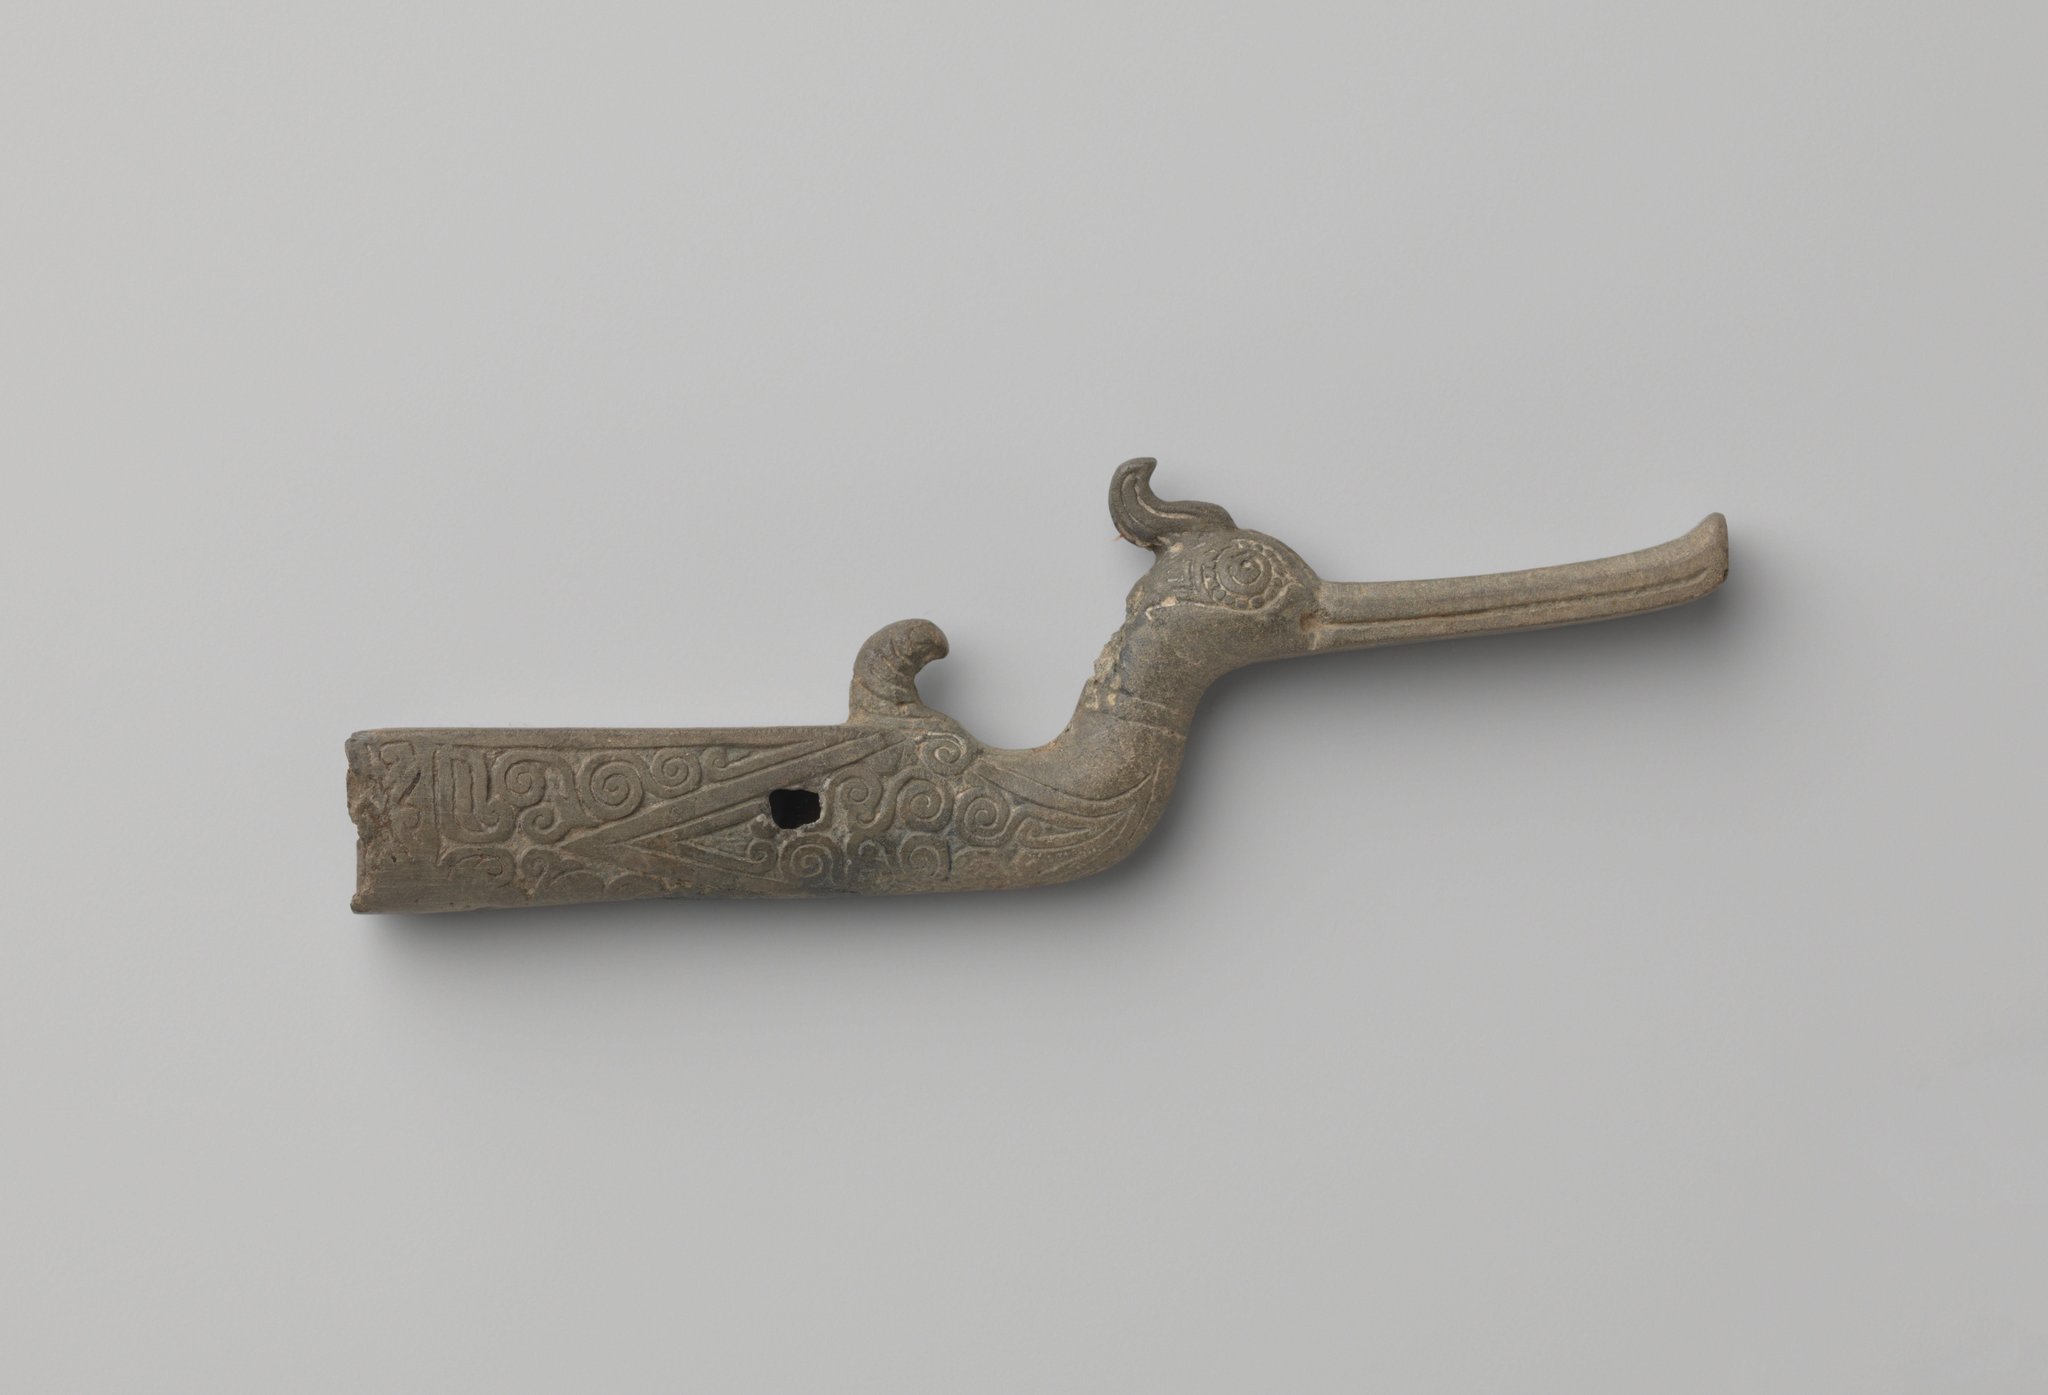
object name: bow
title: Fragment van een boog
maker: Anonymous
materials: bronze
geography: china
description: Part of a canopy shaped like a bird's head. China. Late Eastern Zhou period (481 - 222 BC). Bronze.